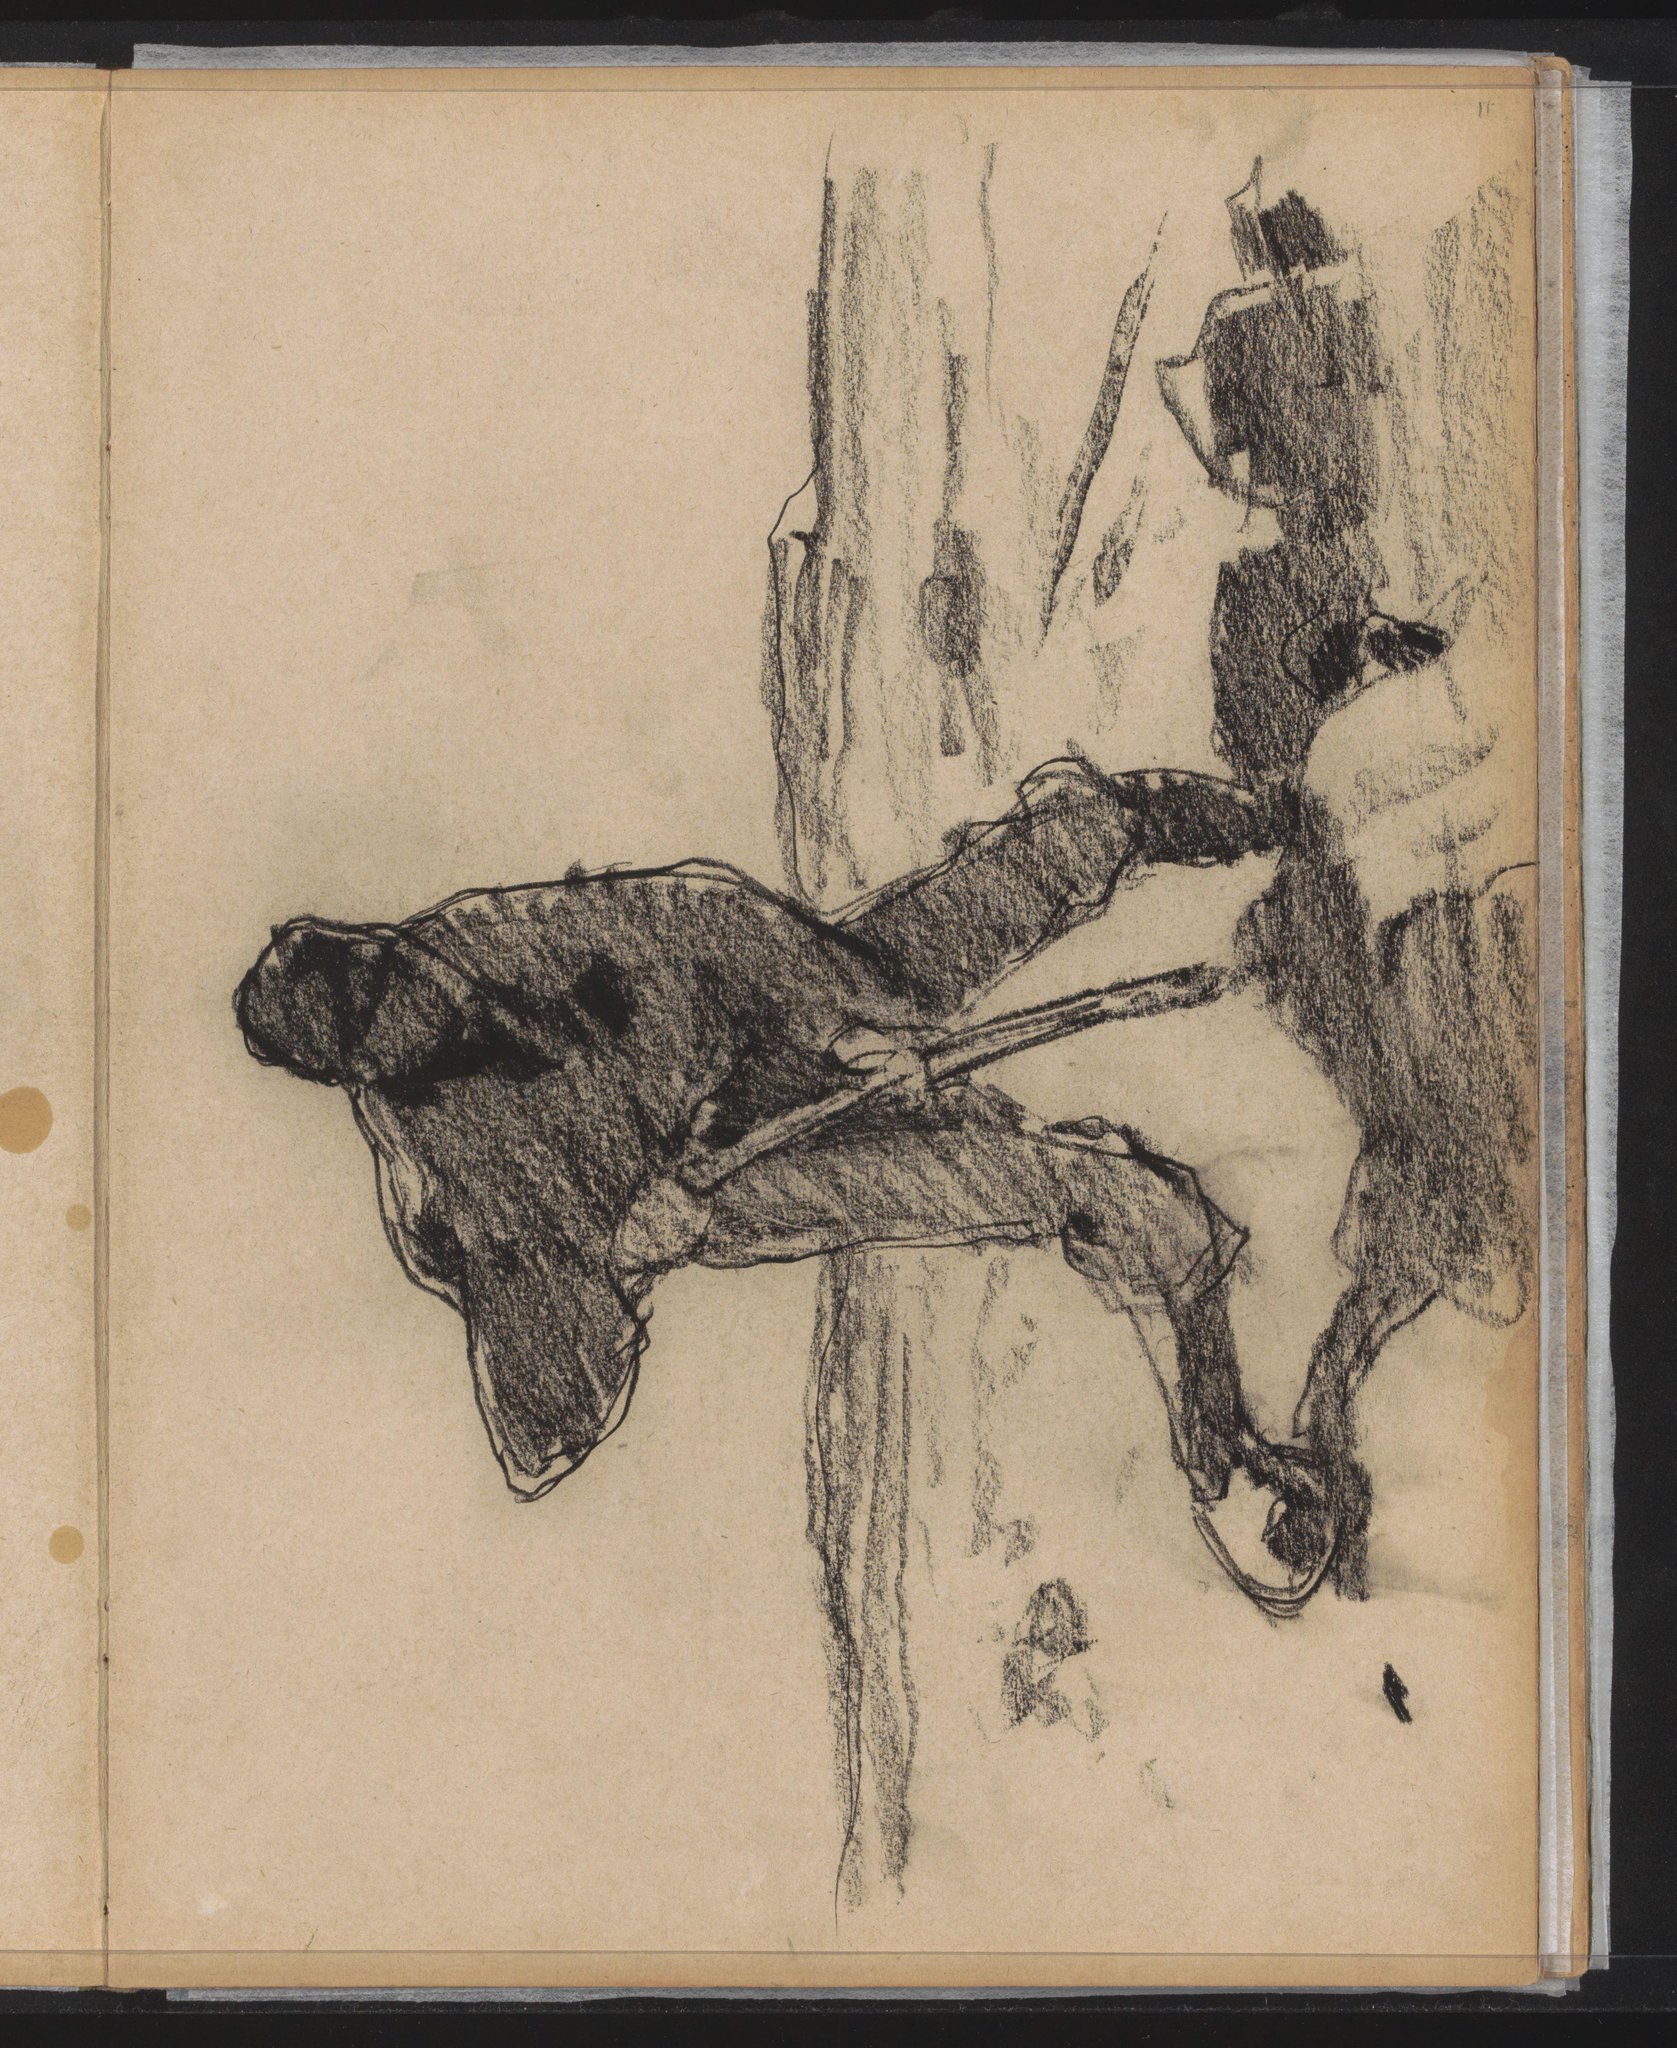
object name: sketchbook leaf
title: Man met spade, mogelijk een heiwerker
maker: willem witsen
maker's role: draughtsman, painter, print maker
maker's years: 1860-1923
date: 1884-1887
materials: chalk, paper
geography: ewijkshoeve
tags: building-site (+ men (labourers)), agricultural implements: spade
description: Pagina 11 uit een schetsboek met 49 bladen.